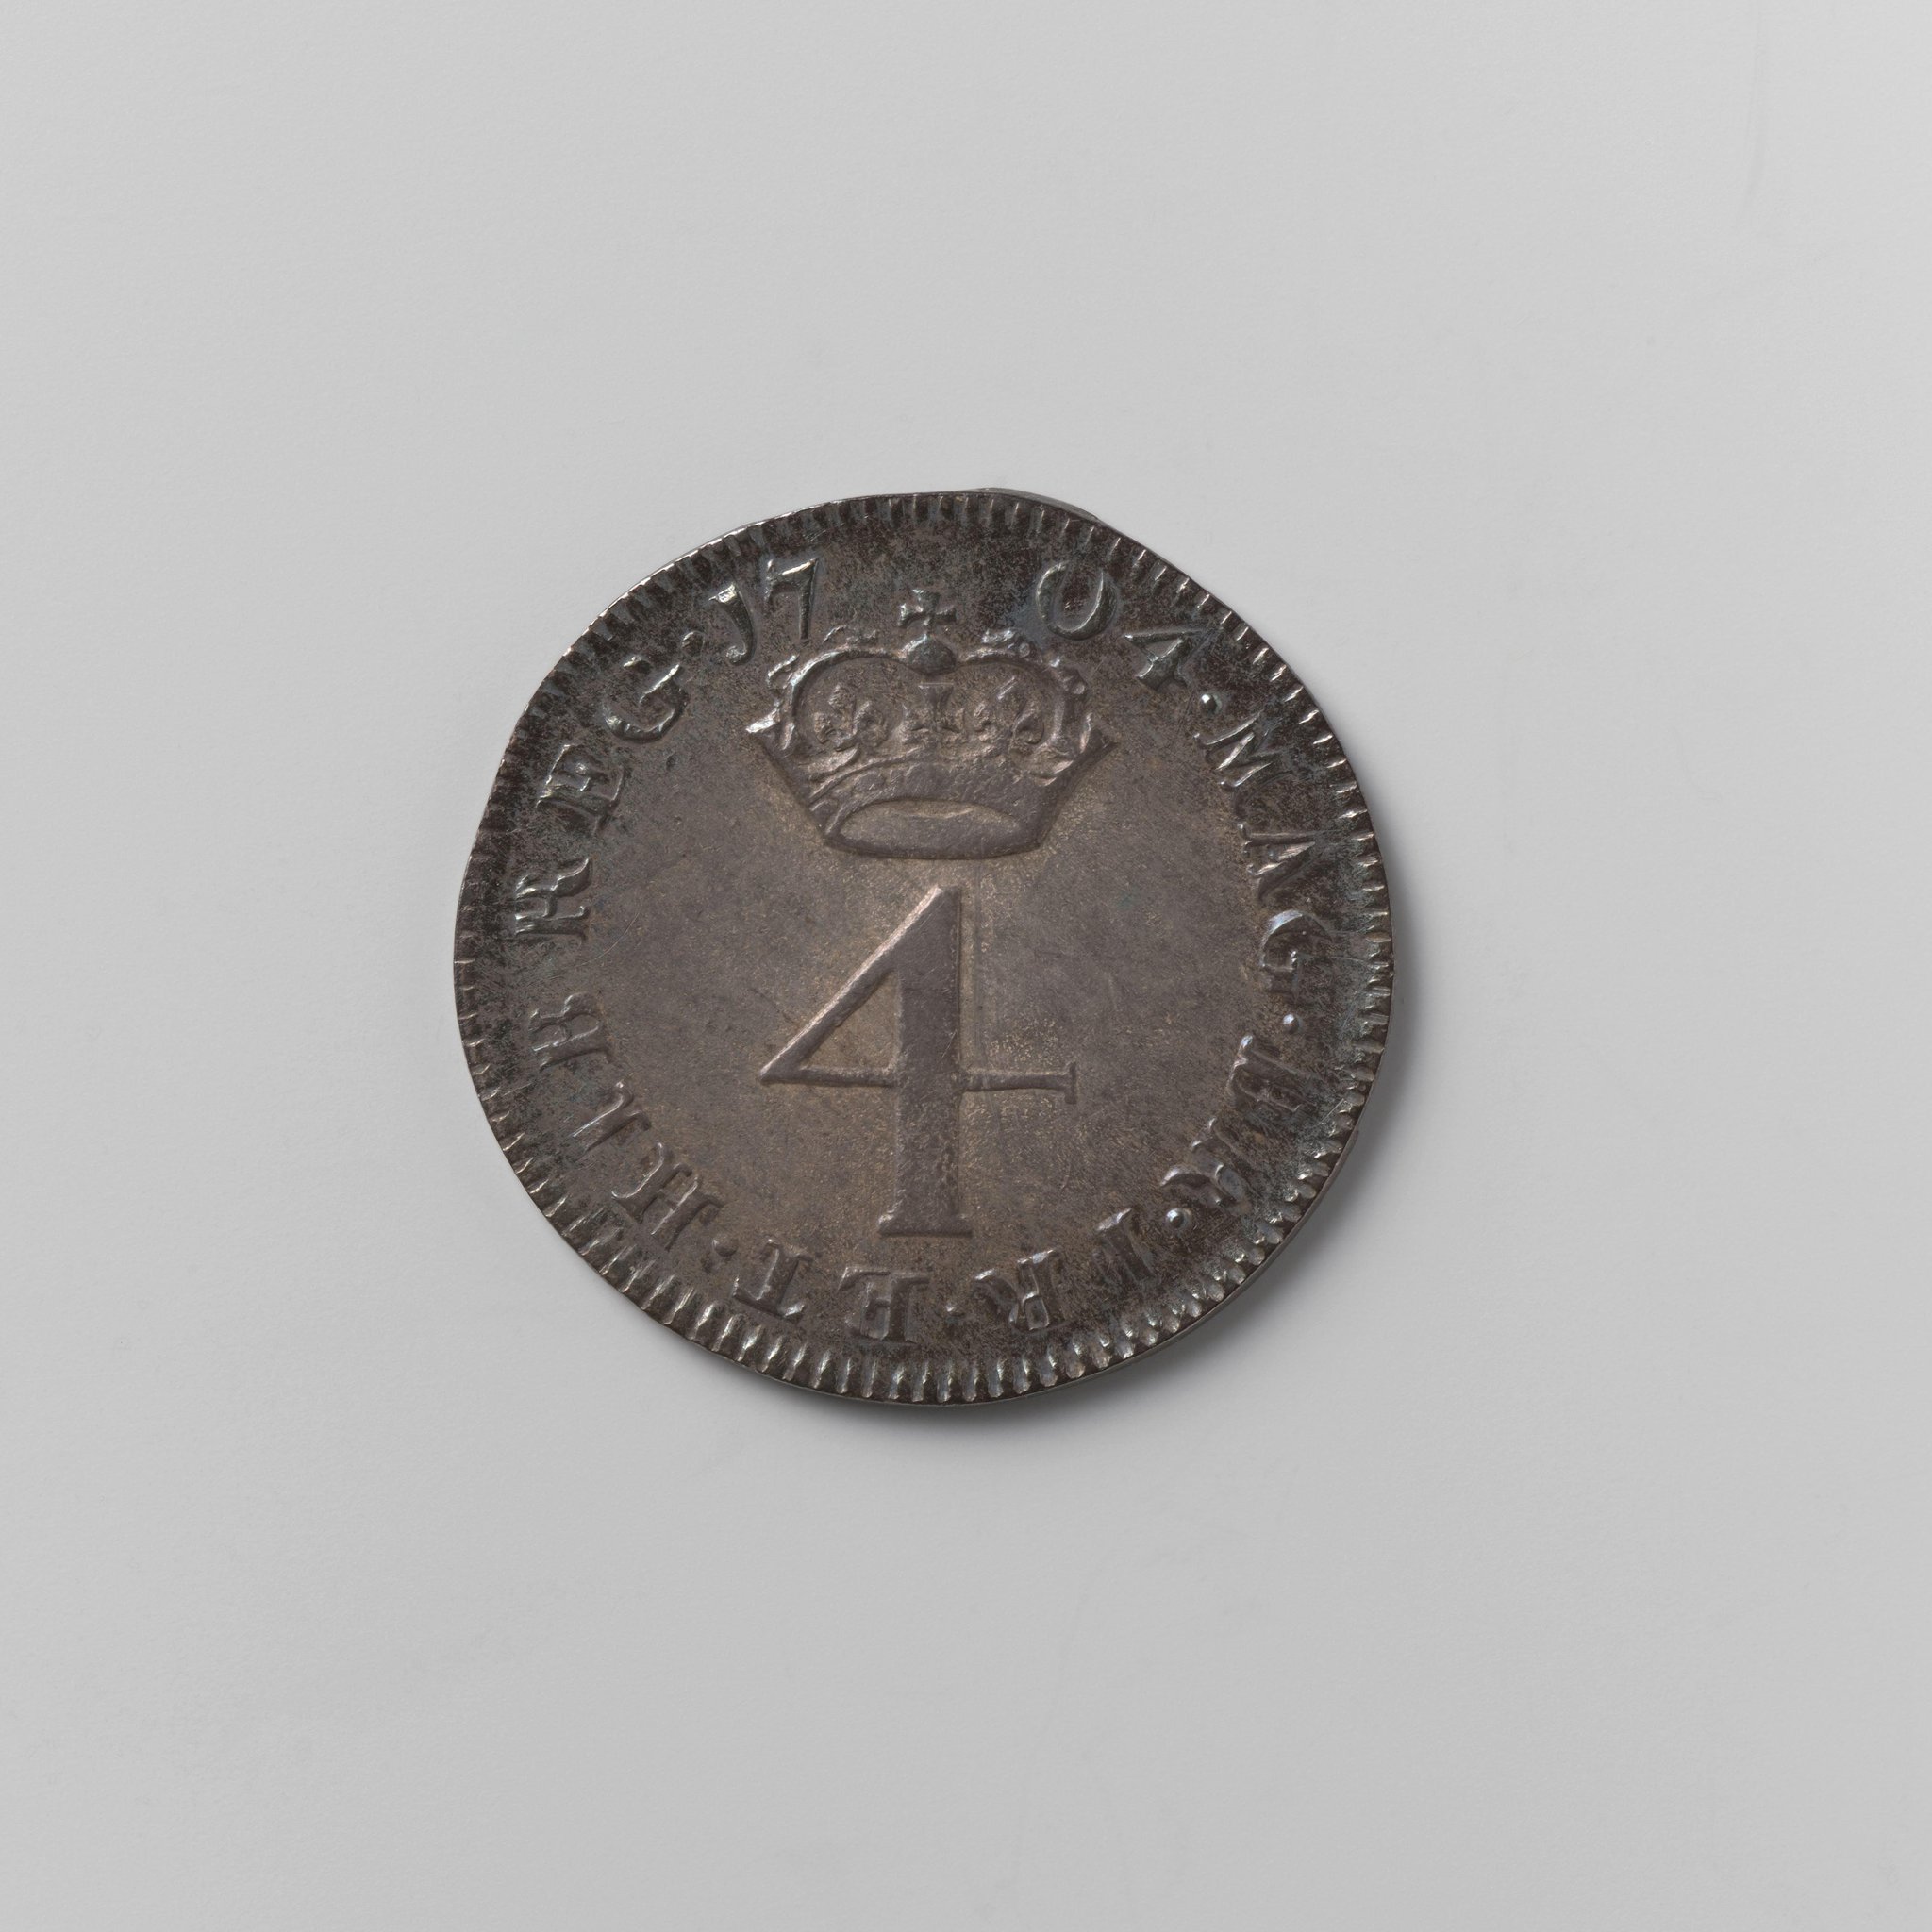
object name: coin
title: 4 pence uit Engeland van Anne, 1704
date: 1704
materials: silver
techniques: striking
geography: london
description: Zilveren munt. Voorzijde: borstbeeld van de koningin naar links. Keerzijde: gekroond cijfer vier. Jaartal bovenaan rondom kroon. Maundy money.